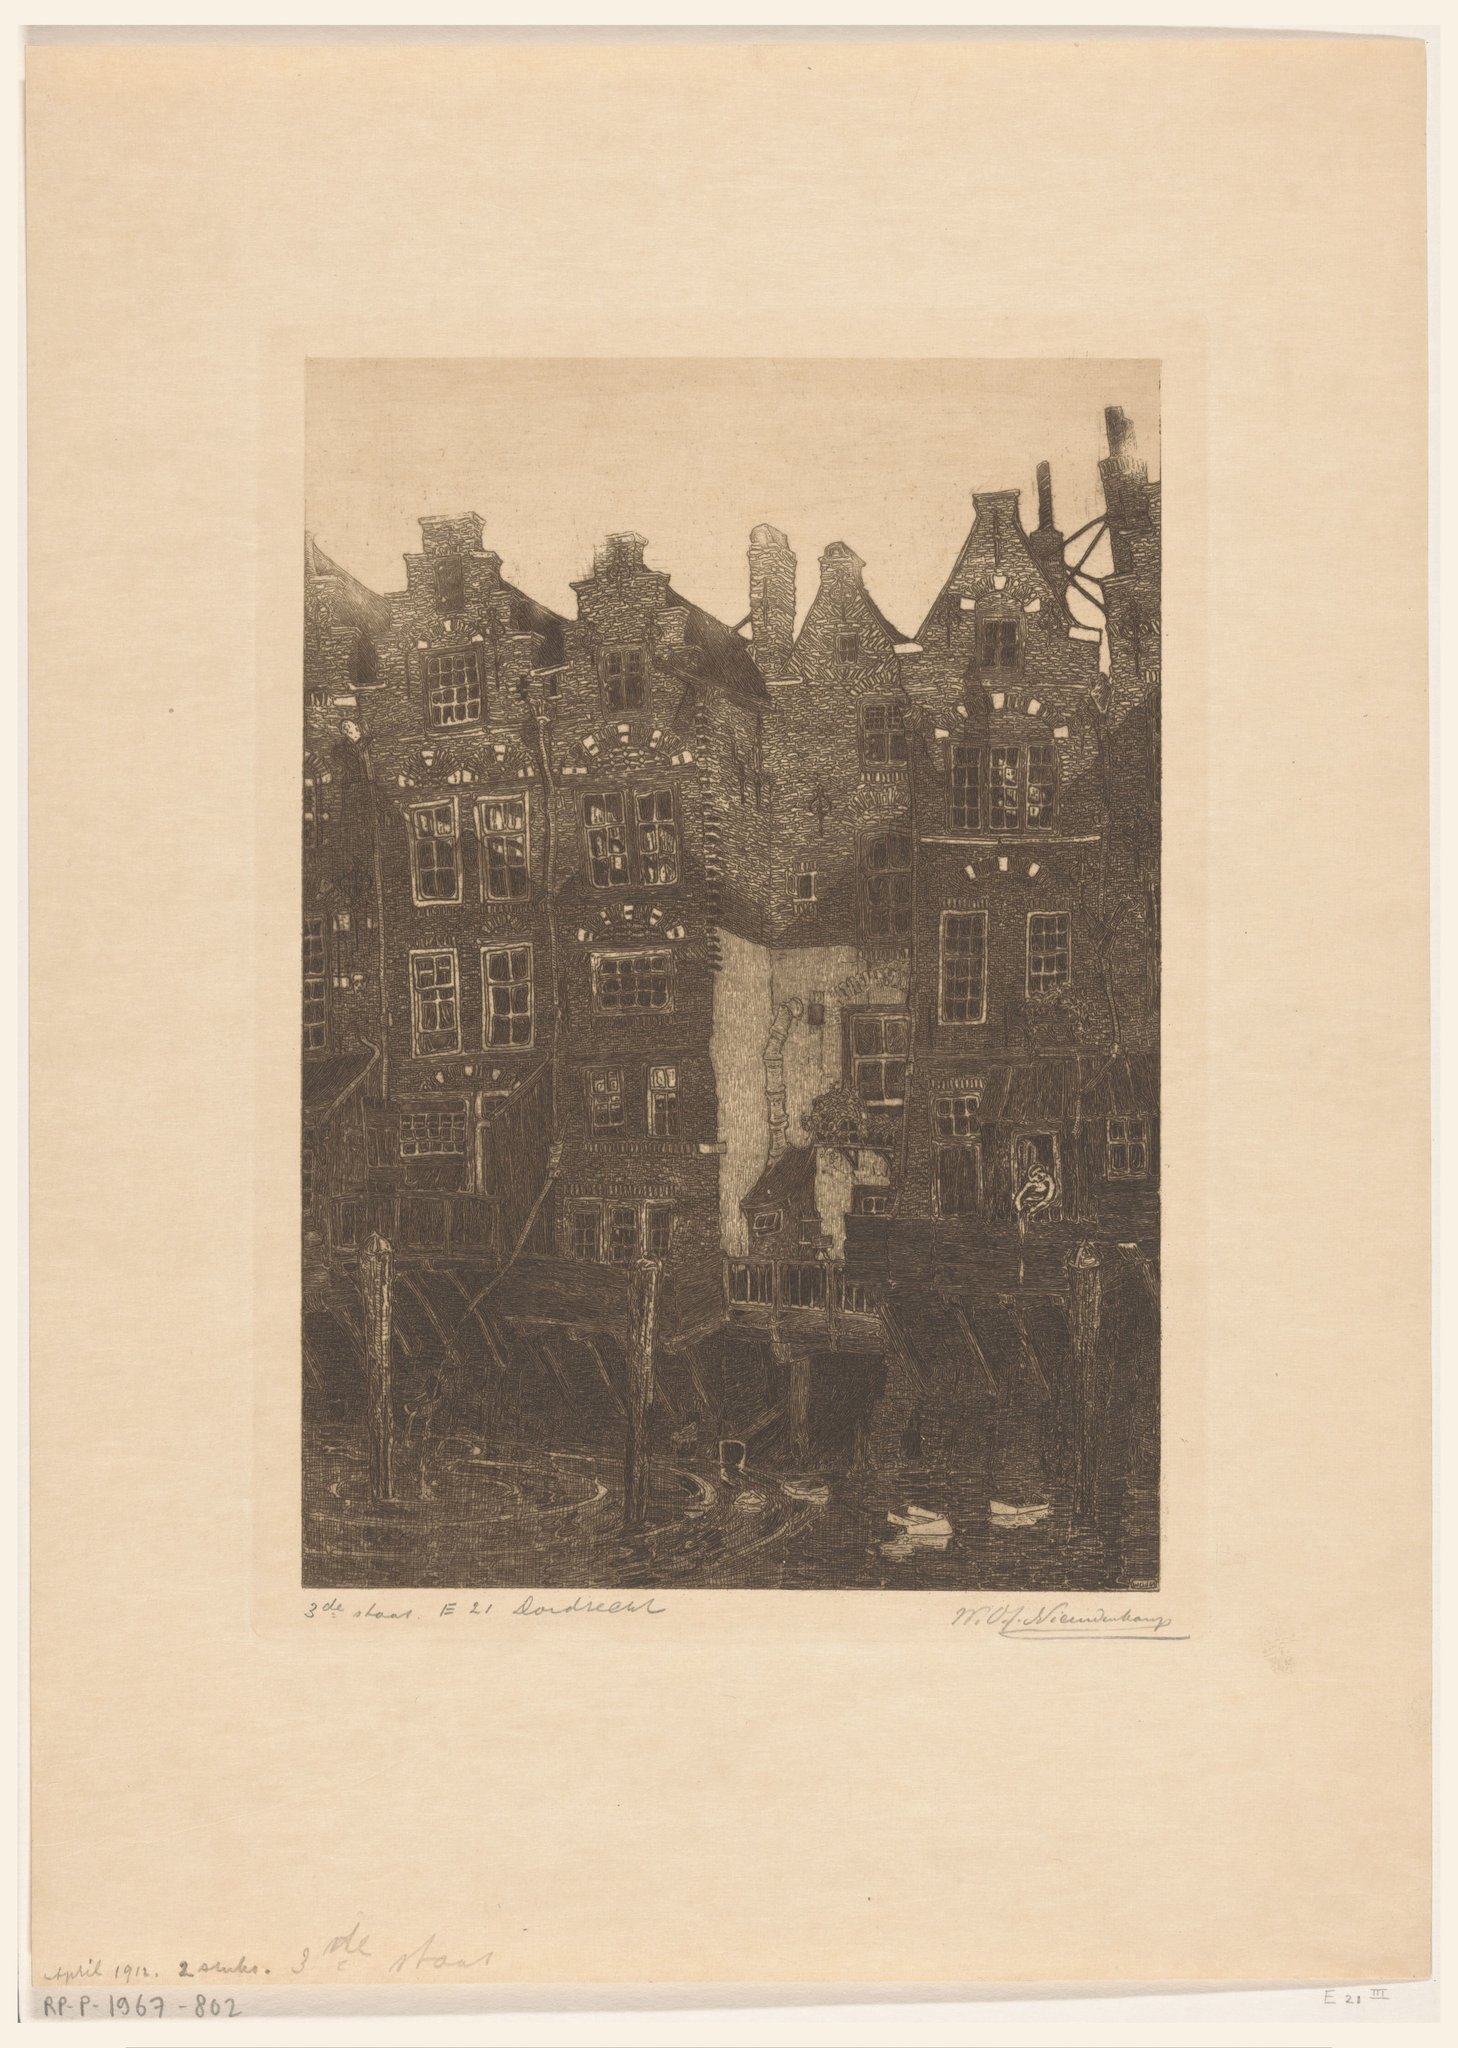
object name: print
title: Dordrecht, zes etsen van W.O.J. Nieuwenkamp en J.M. Graadt van Roggen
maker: wijnand otto jan nieuwenkamp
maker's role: draughtsman, print maker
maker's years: 1874-1950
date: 1897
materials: paper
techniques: etching, intaglio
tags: canals, waters (in city)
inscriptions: collector's mark: Lugt 2228, collector's mark: Lugt 2760